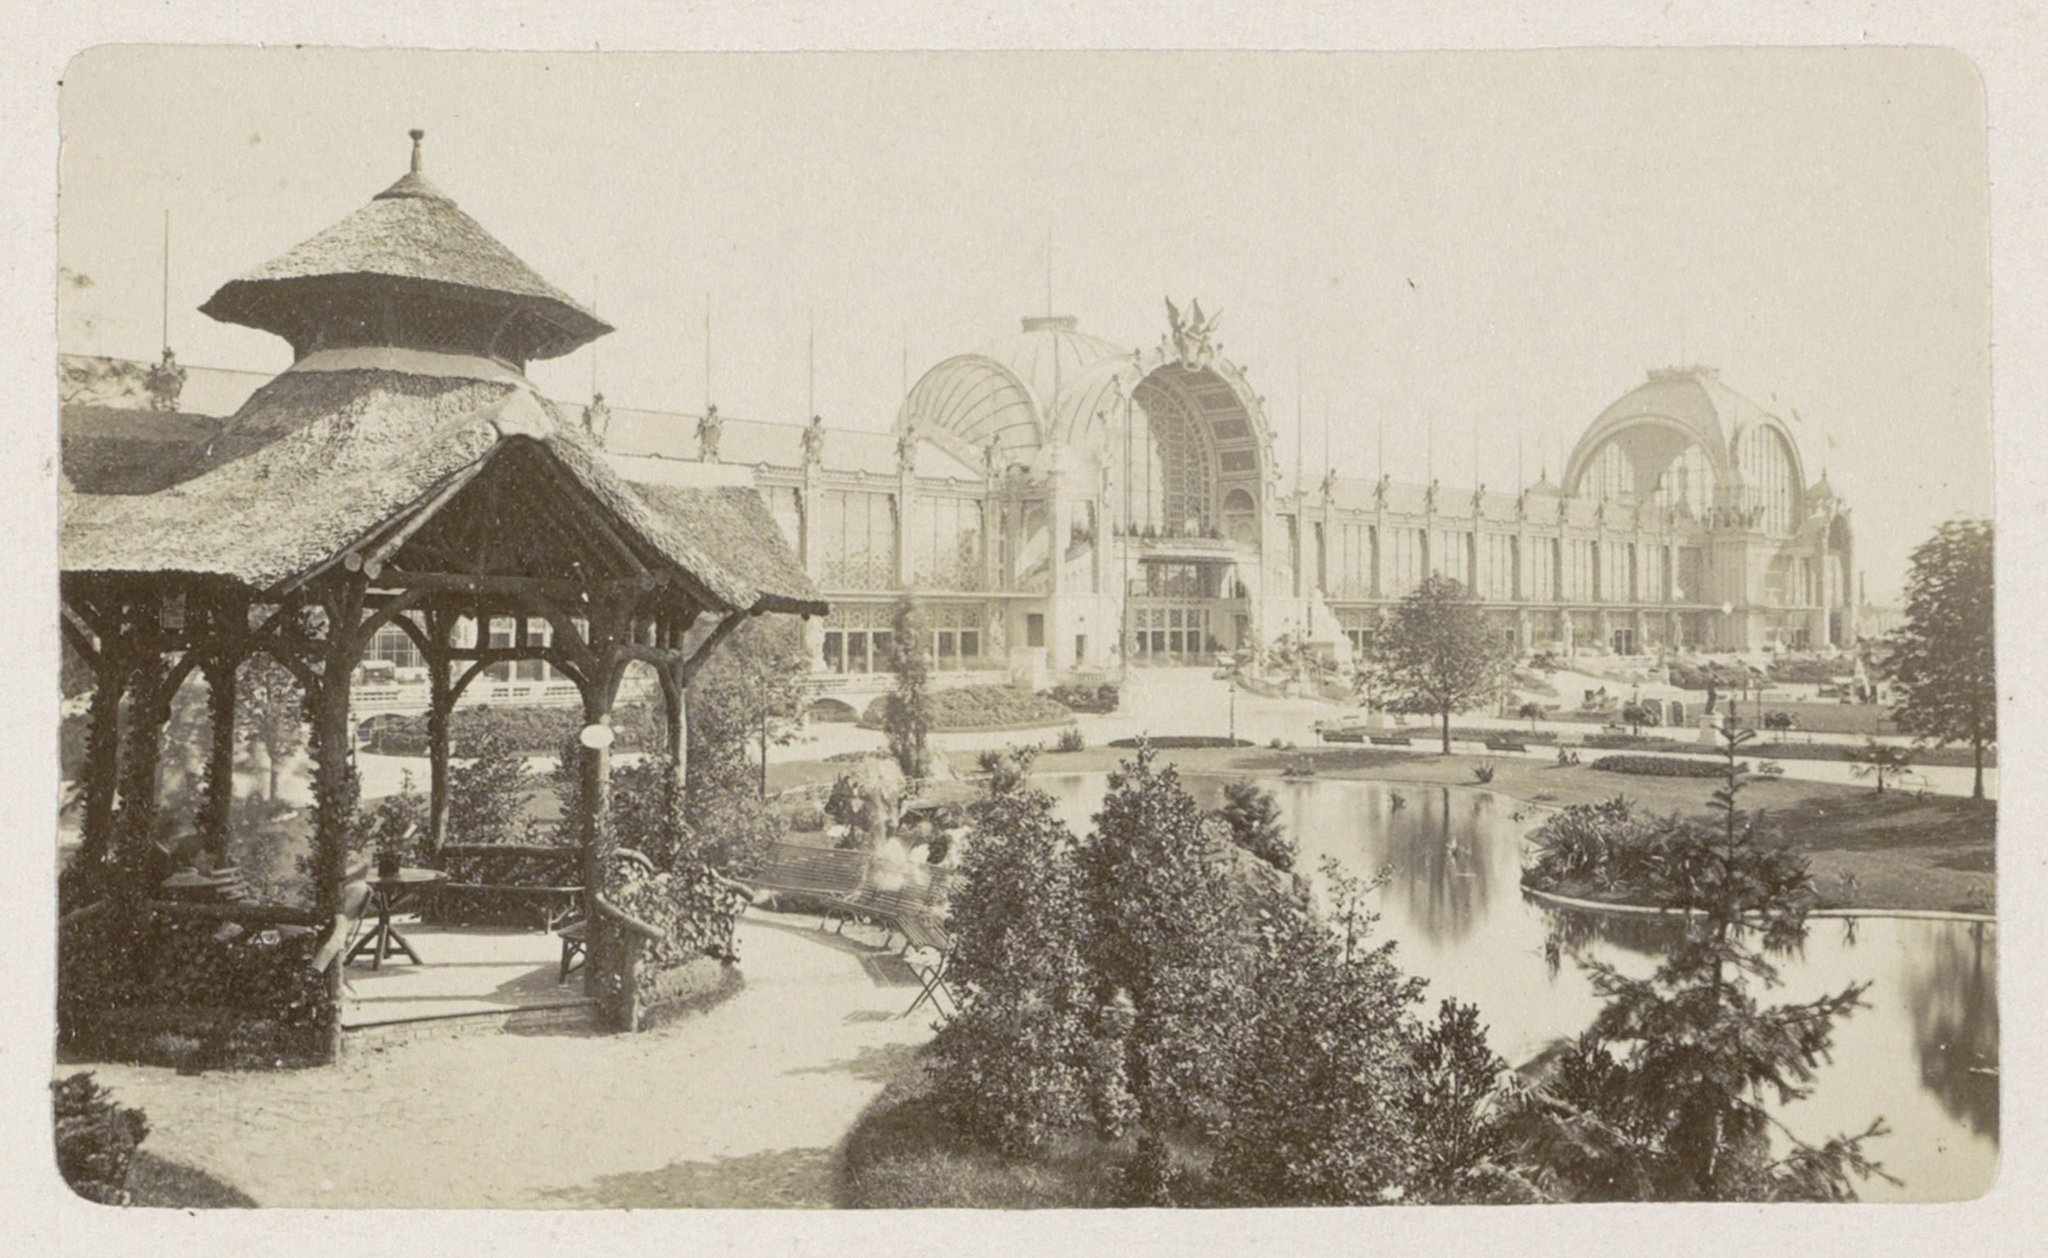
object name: photograph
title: Deel van het expositieterrein op de Wereldtentoonstelling te Parijs in 1889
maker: Anonymous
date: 1889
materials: photographic support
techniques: albumen print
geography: paris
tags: world fair, world exhibition, paris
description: Onderdeel van Reisalbum Europese steden, vermoedelijk Zweeds.